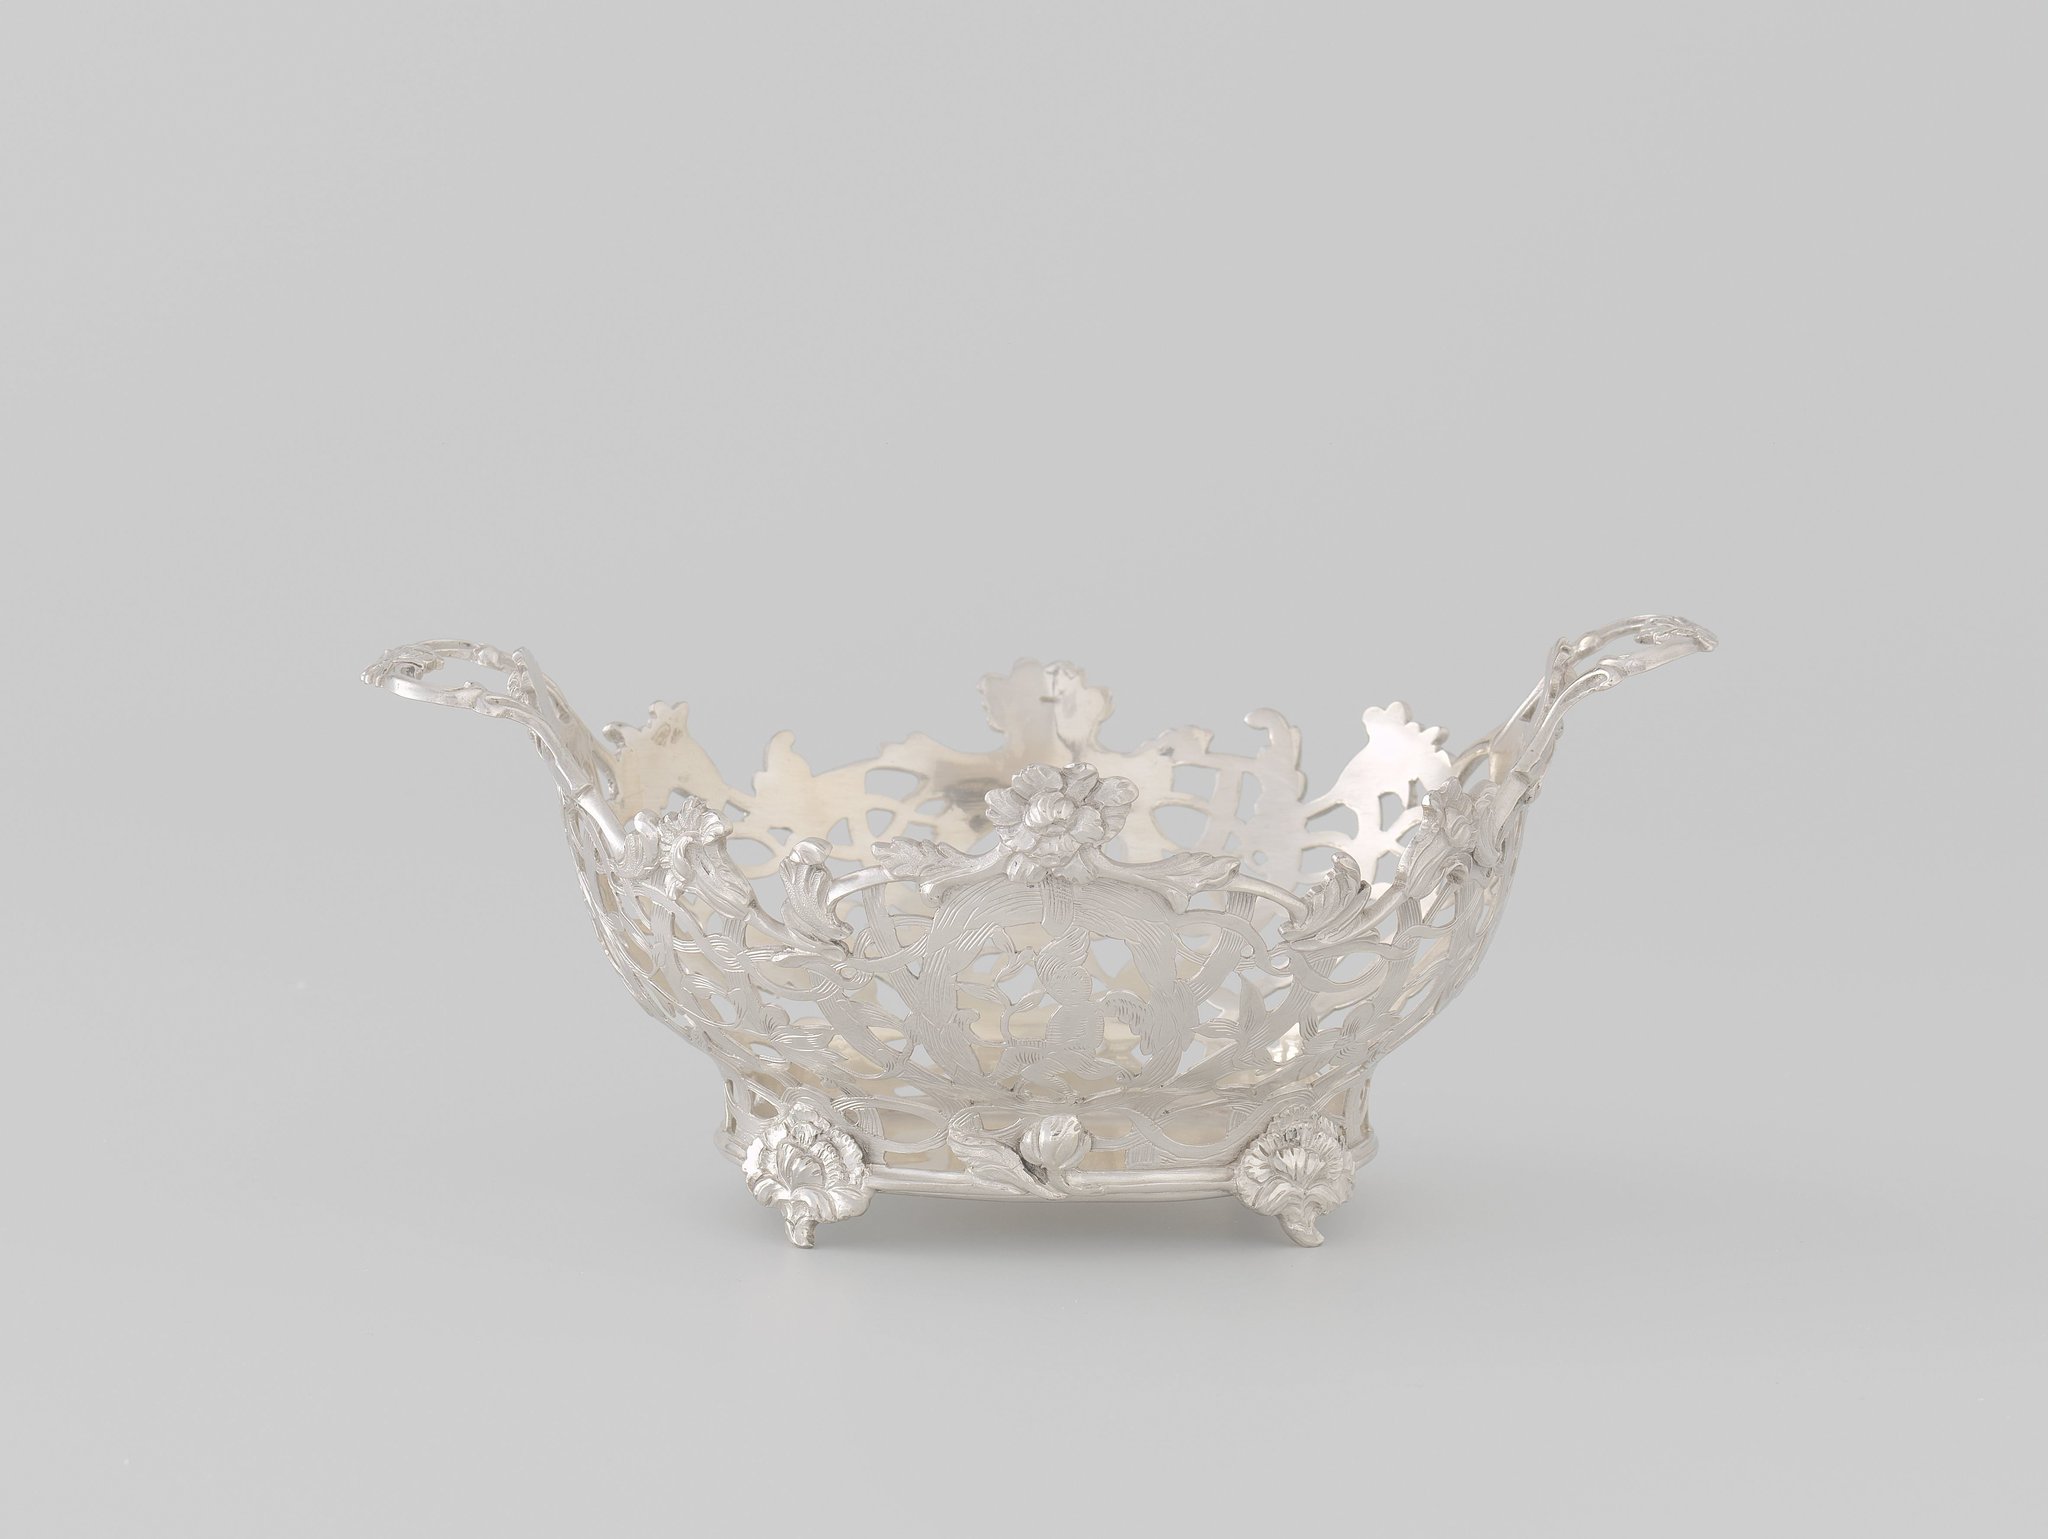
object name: basket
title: Mand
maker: johannes horstman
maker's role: silversmith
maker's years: 1721-1804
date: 1772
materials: silver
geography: amsterdam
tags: flowers ~ ornament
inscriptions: duty mark, town mark, inscription: ‘IvH’, date letter: ‘N’, maker's mark, alloy mark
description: Basket. Silver. Amsterdam, 1772, attributed to Johannes Hartsman. Given by Messrs Premsela and Hamburger, 1952.